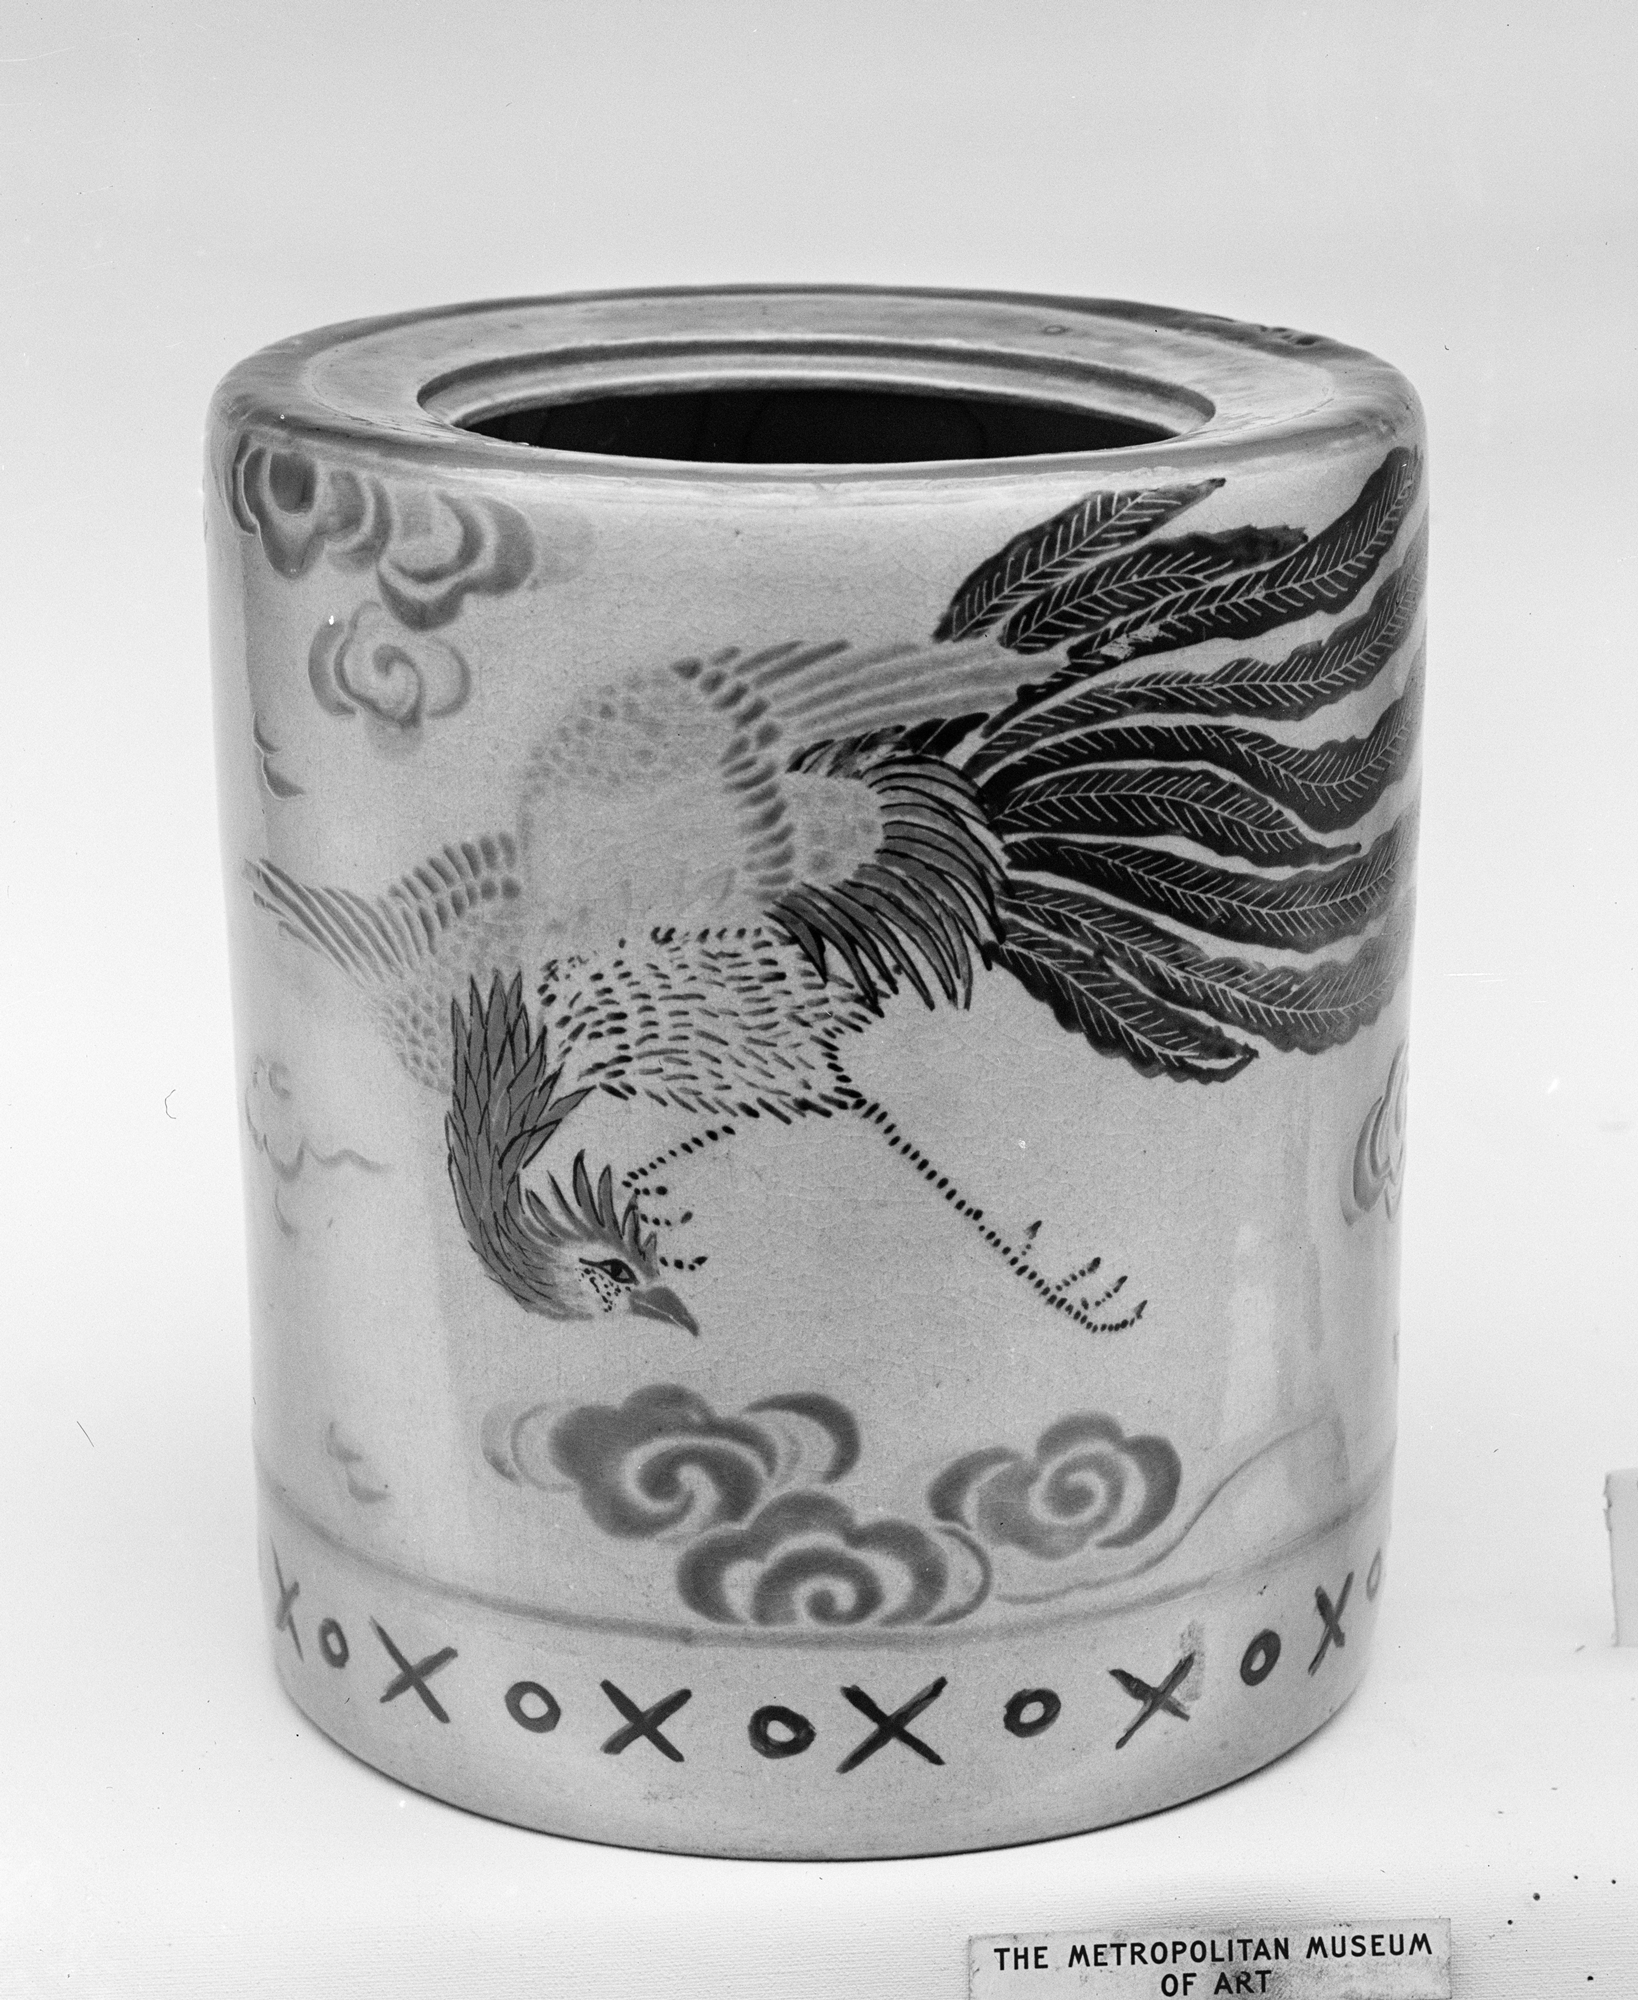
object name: fire pot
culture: japanese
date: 1750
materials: clay, enamel, glaze, gold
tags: birds